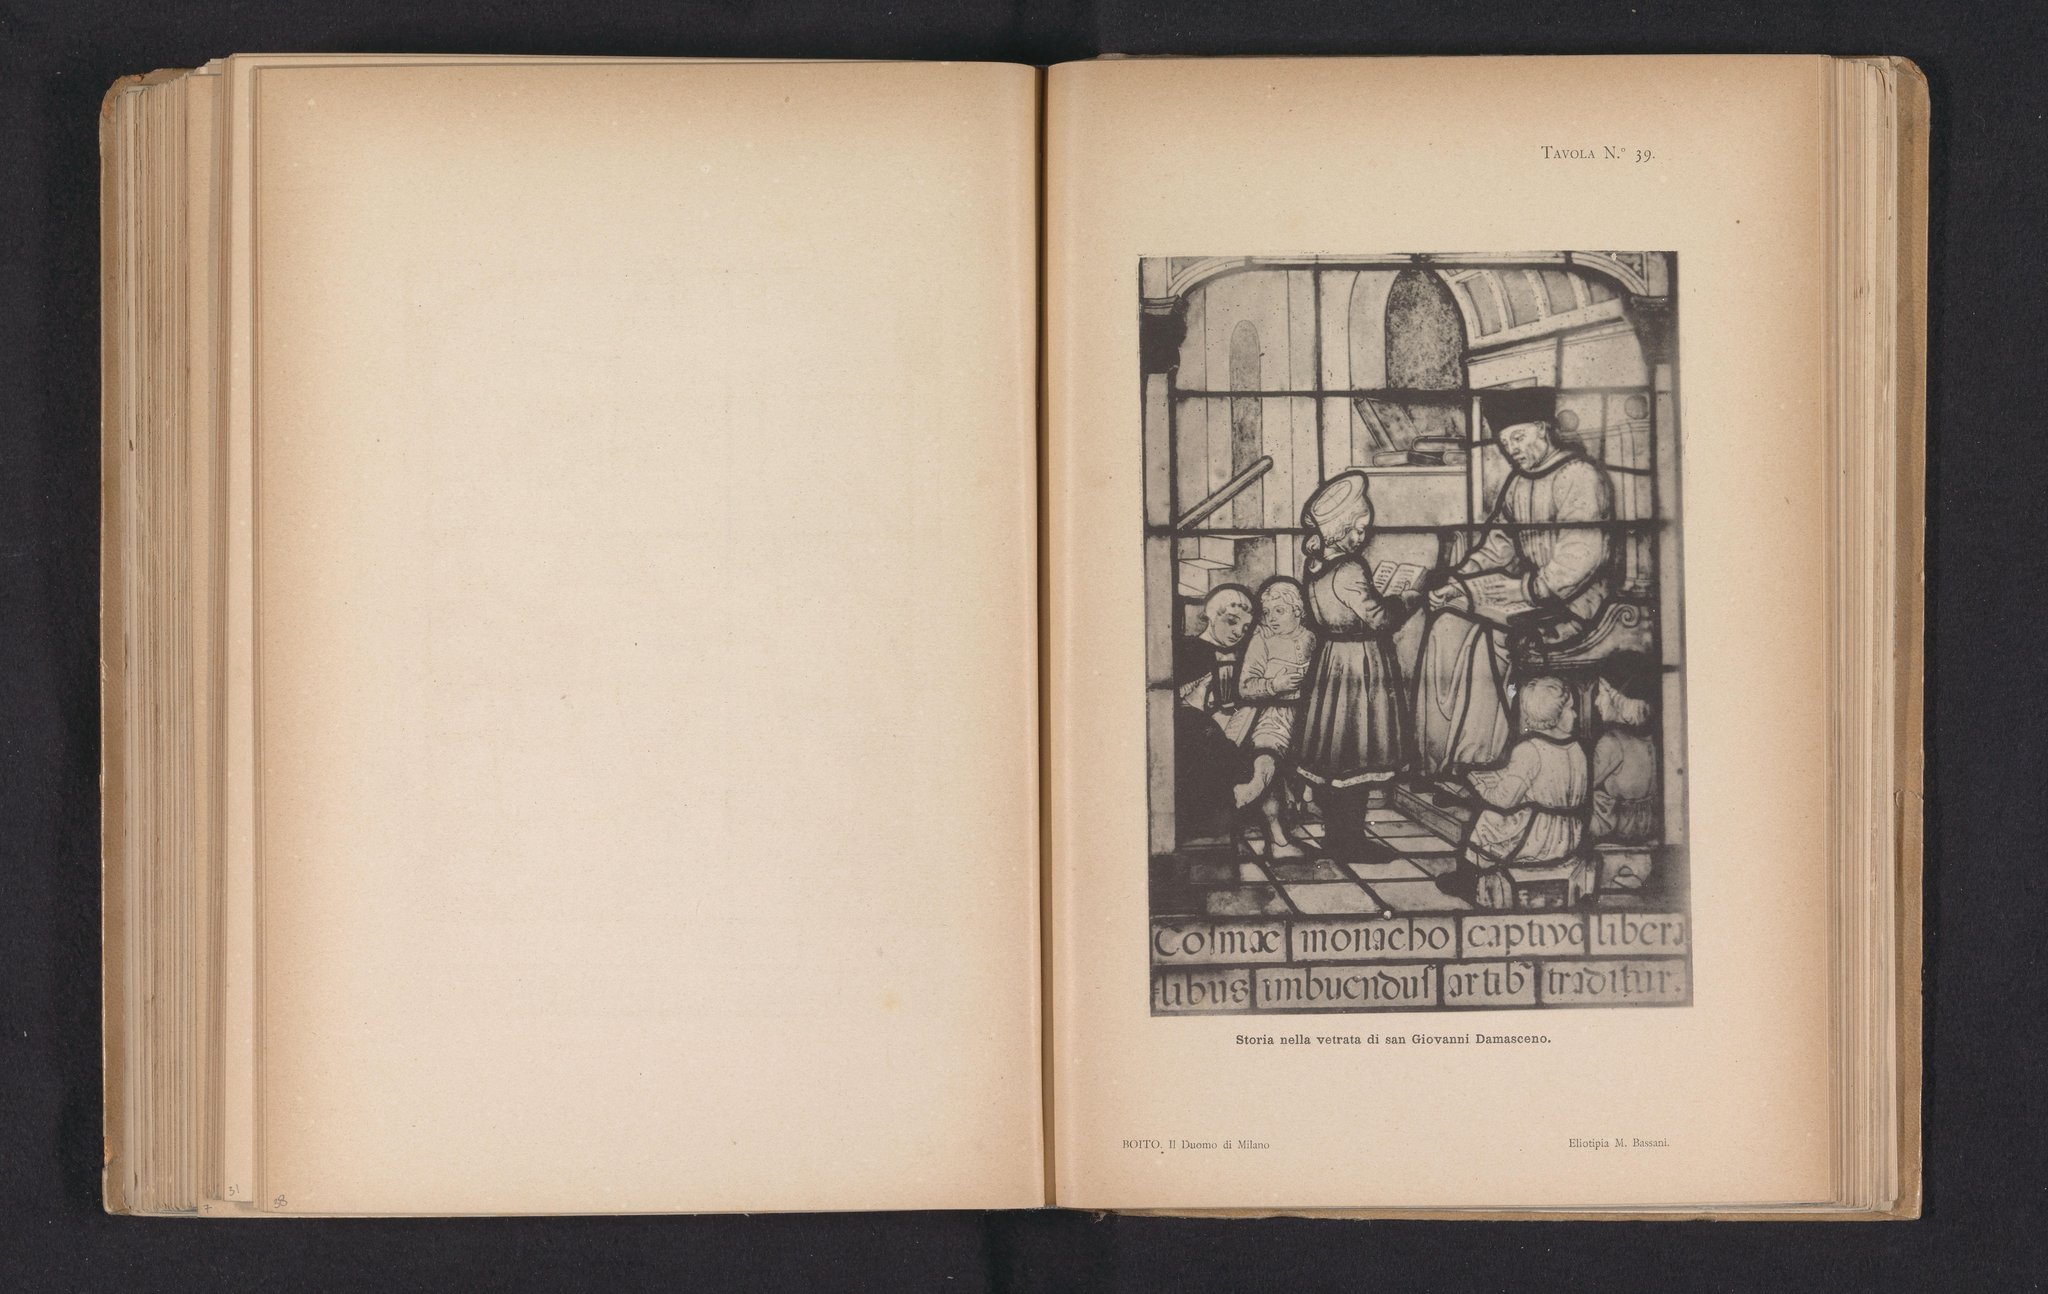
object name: photomechanical print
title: Storia nella vetrata di san Giovanni Damasceno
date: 1879-1889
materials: paper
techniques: photograph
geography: milan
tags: church-window, e.g. rose-window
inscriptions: number: ‘Tavola No. 39.’